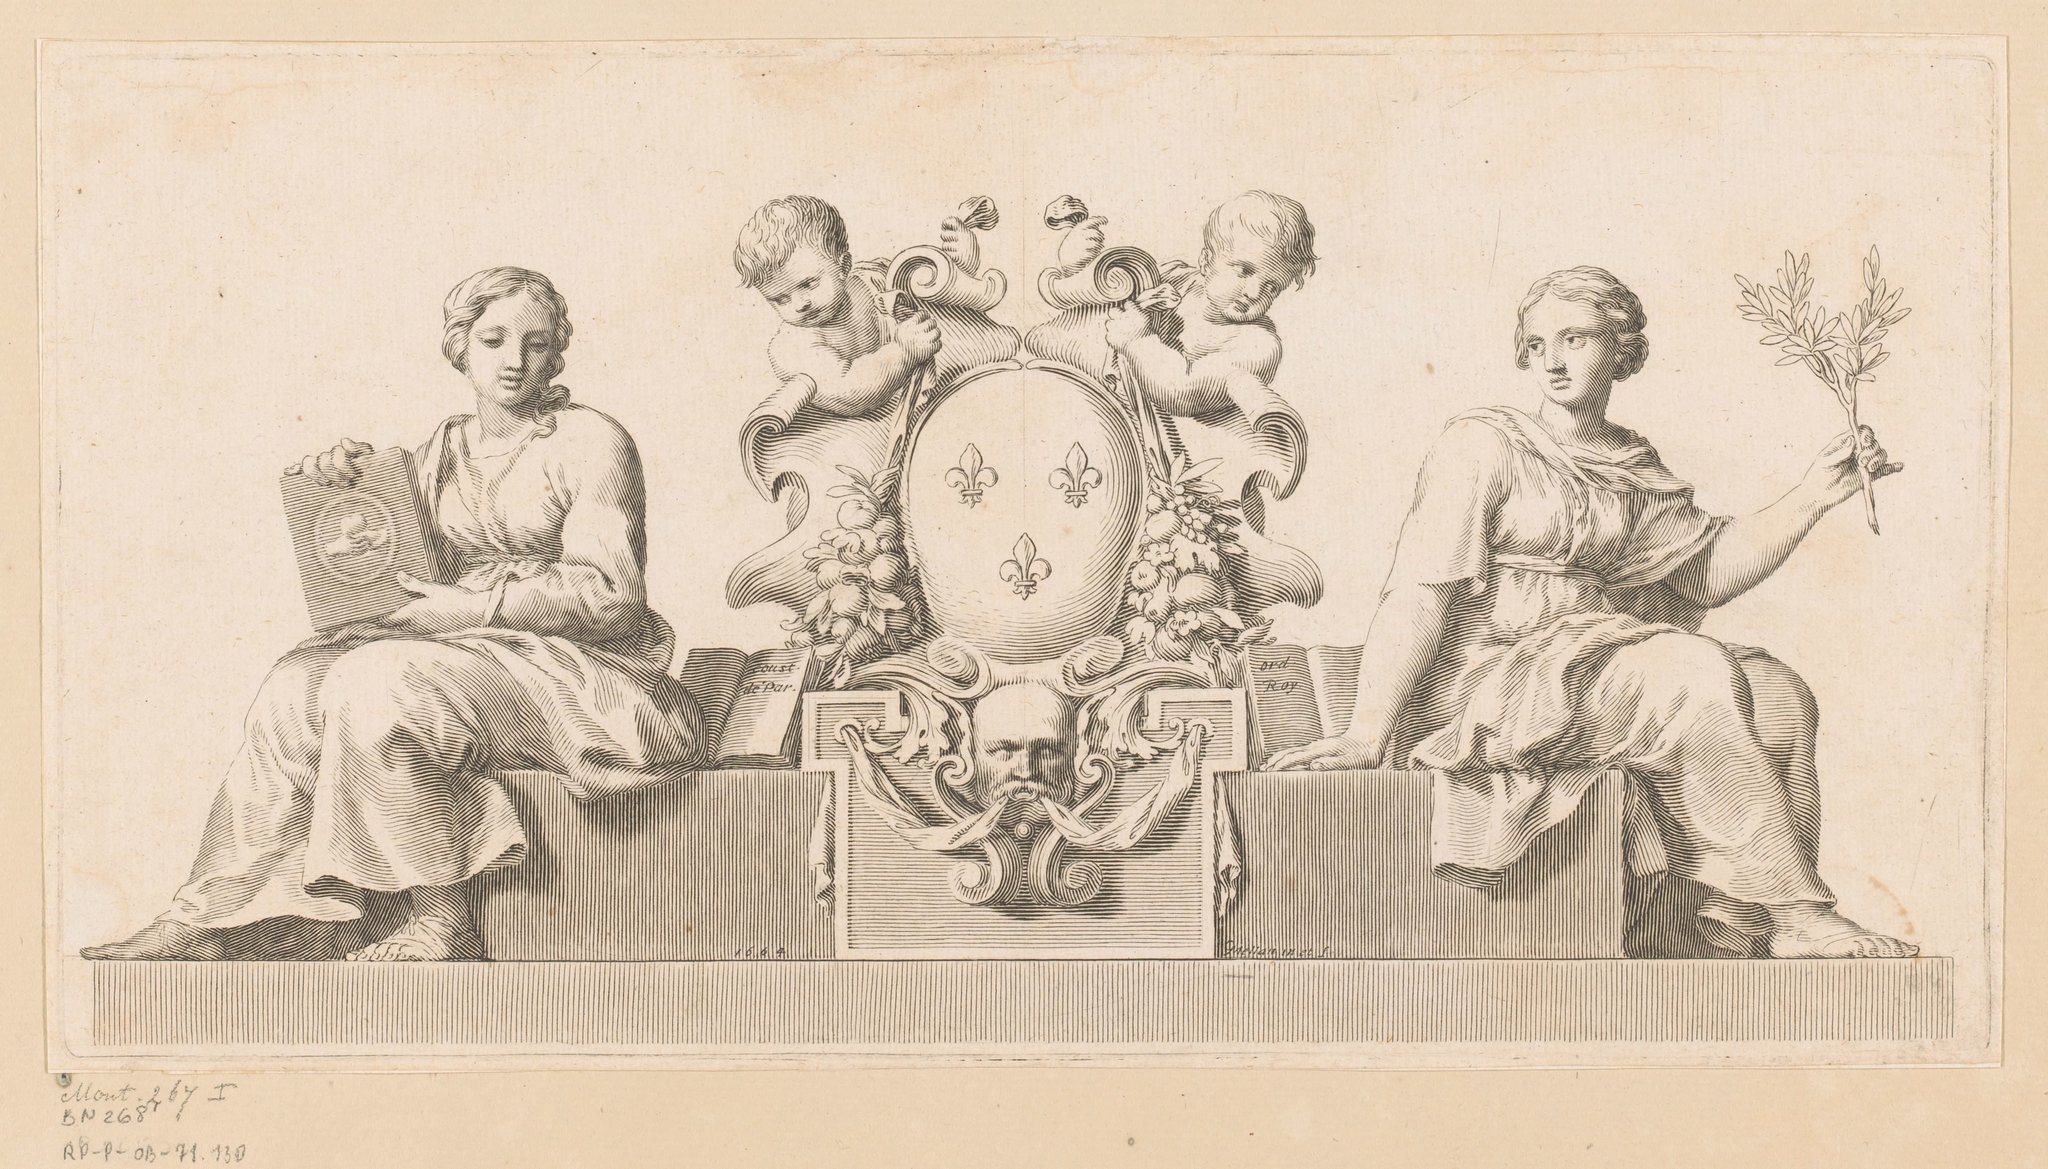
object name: print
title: Wapen van de notarissen van het Châtelet in Parijs met personificaties van het Goede Geloof en de Wet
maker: claude mellan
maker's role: draughtsman, print maker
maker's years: 1598-1688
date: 1664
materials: paper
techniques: engraving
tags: armorial bearing, heraldry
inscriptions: collector's mark: Lugt 240